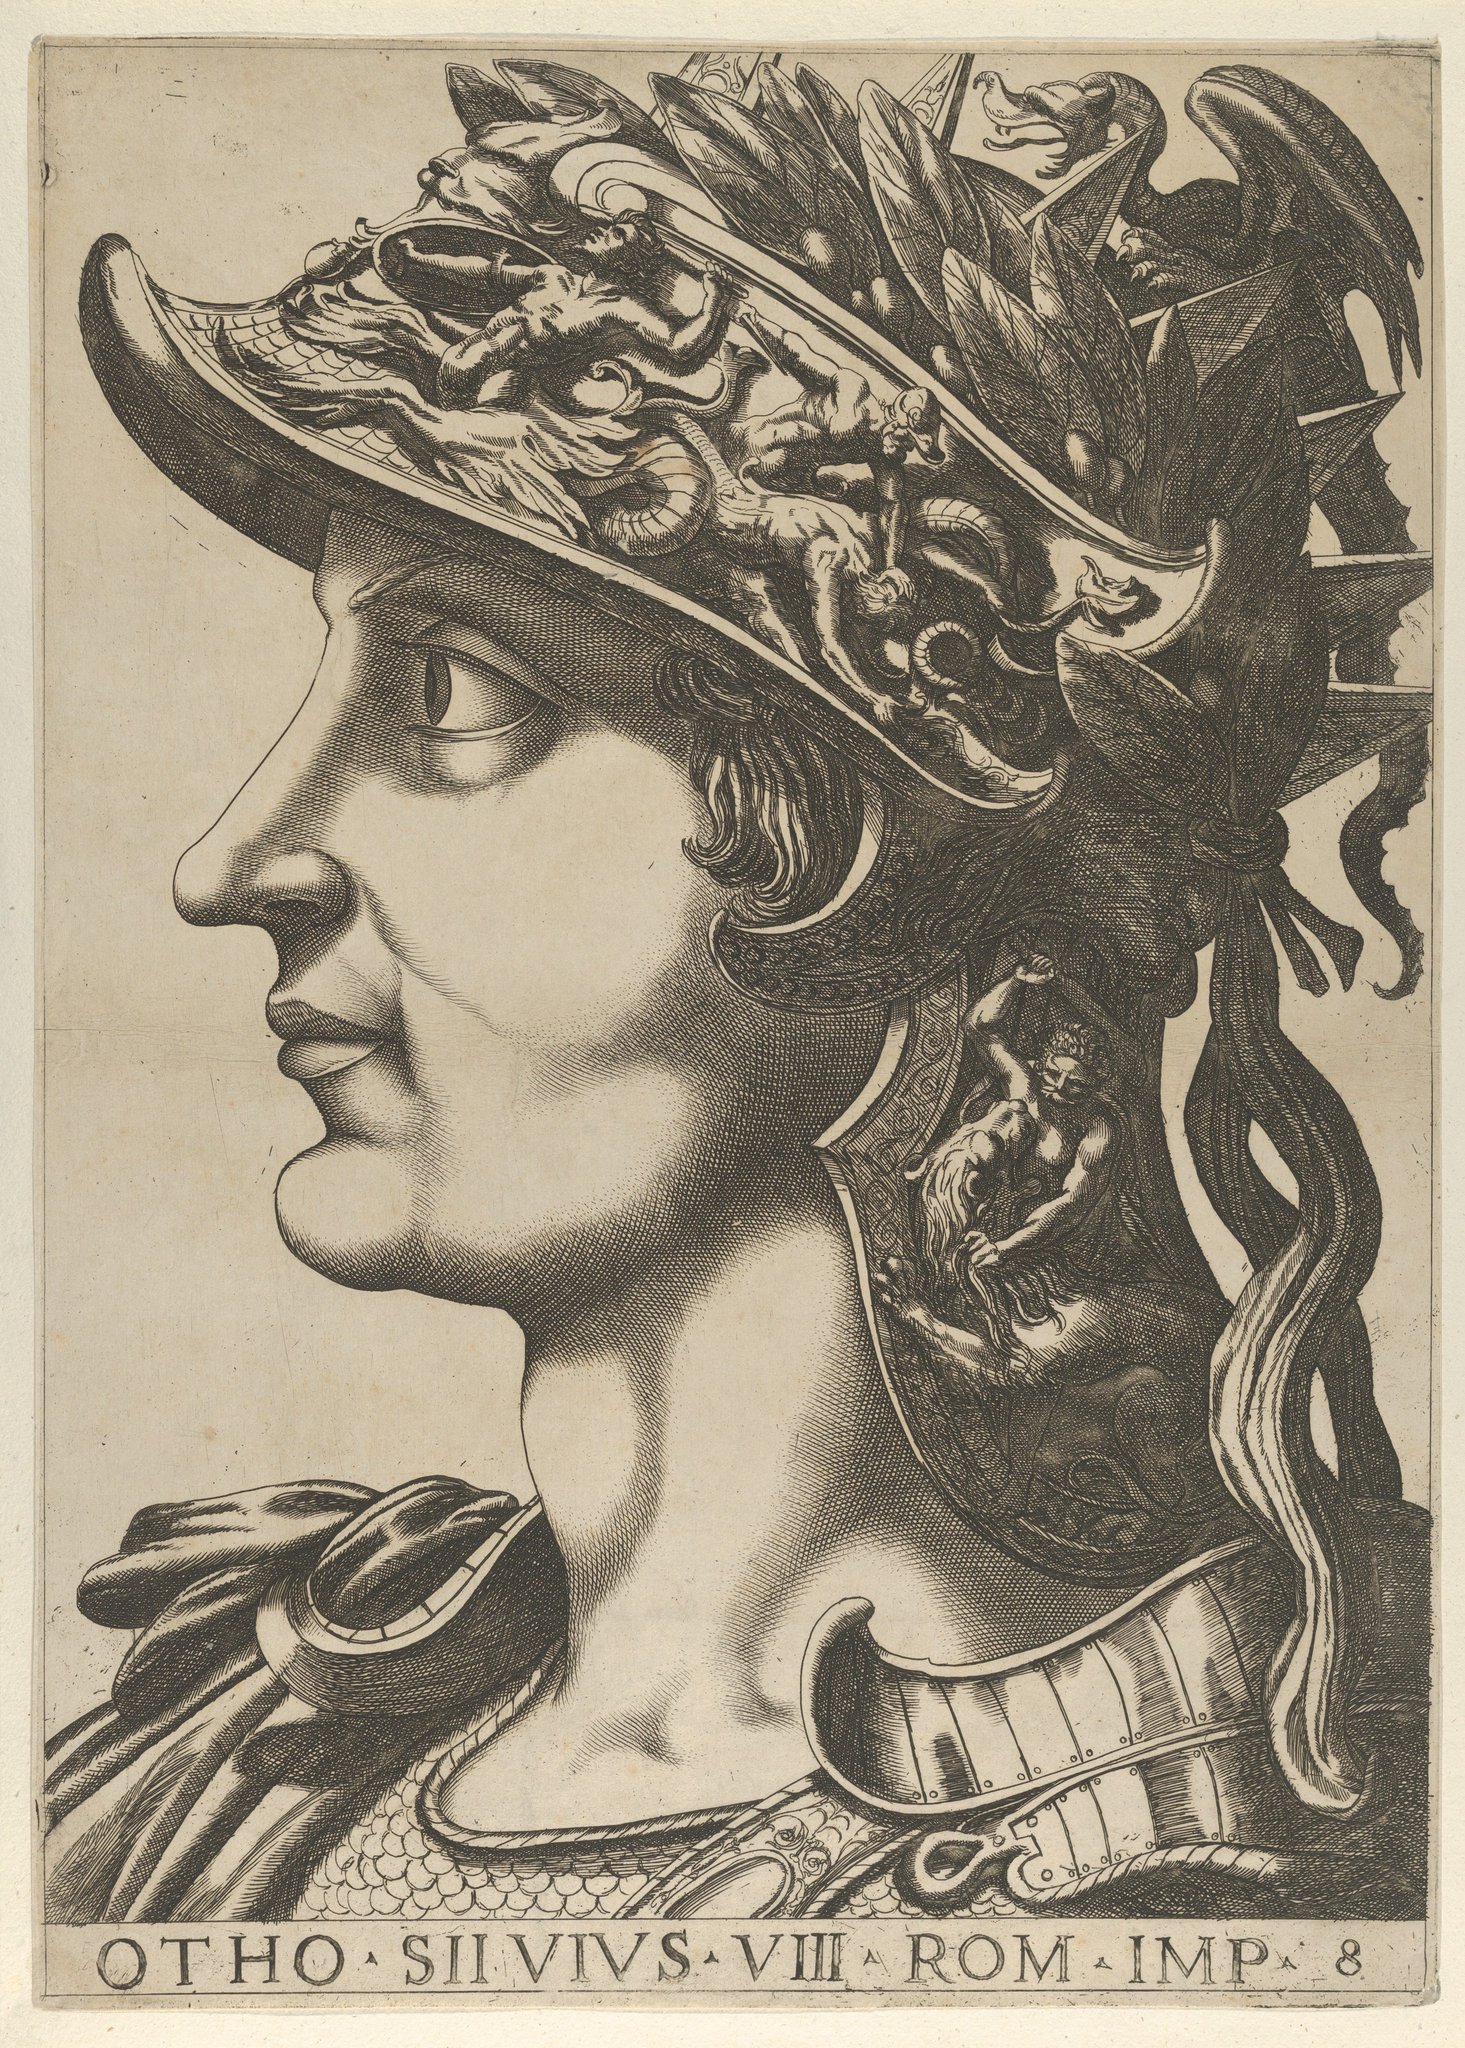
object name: print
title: Plate 8: Otho in profile facing left, from "The Twelve Caesars"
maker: Anonymous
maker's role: artist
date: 1610-1640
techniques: engraving, etching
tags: helmets,emperors,men